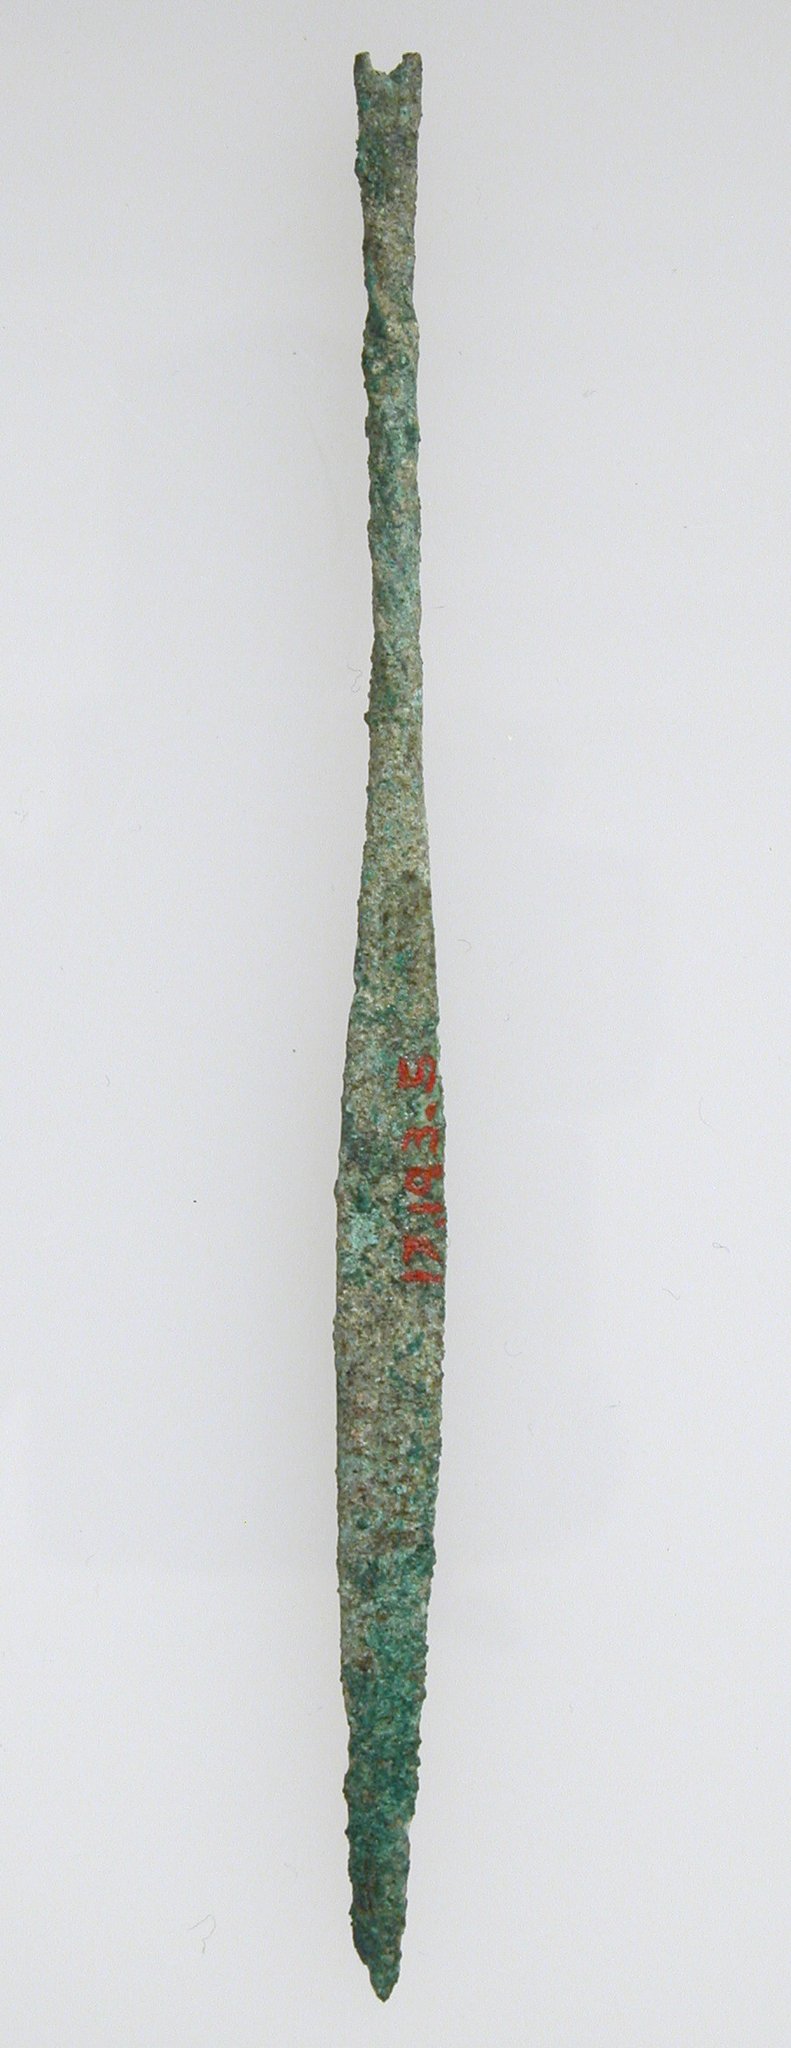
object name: needle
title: Flat Needle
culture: roman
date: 1-400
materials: copper alloy